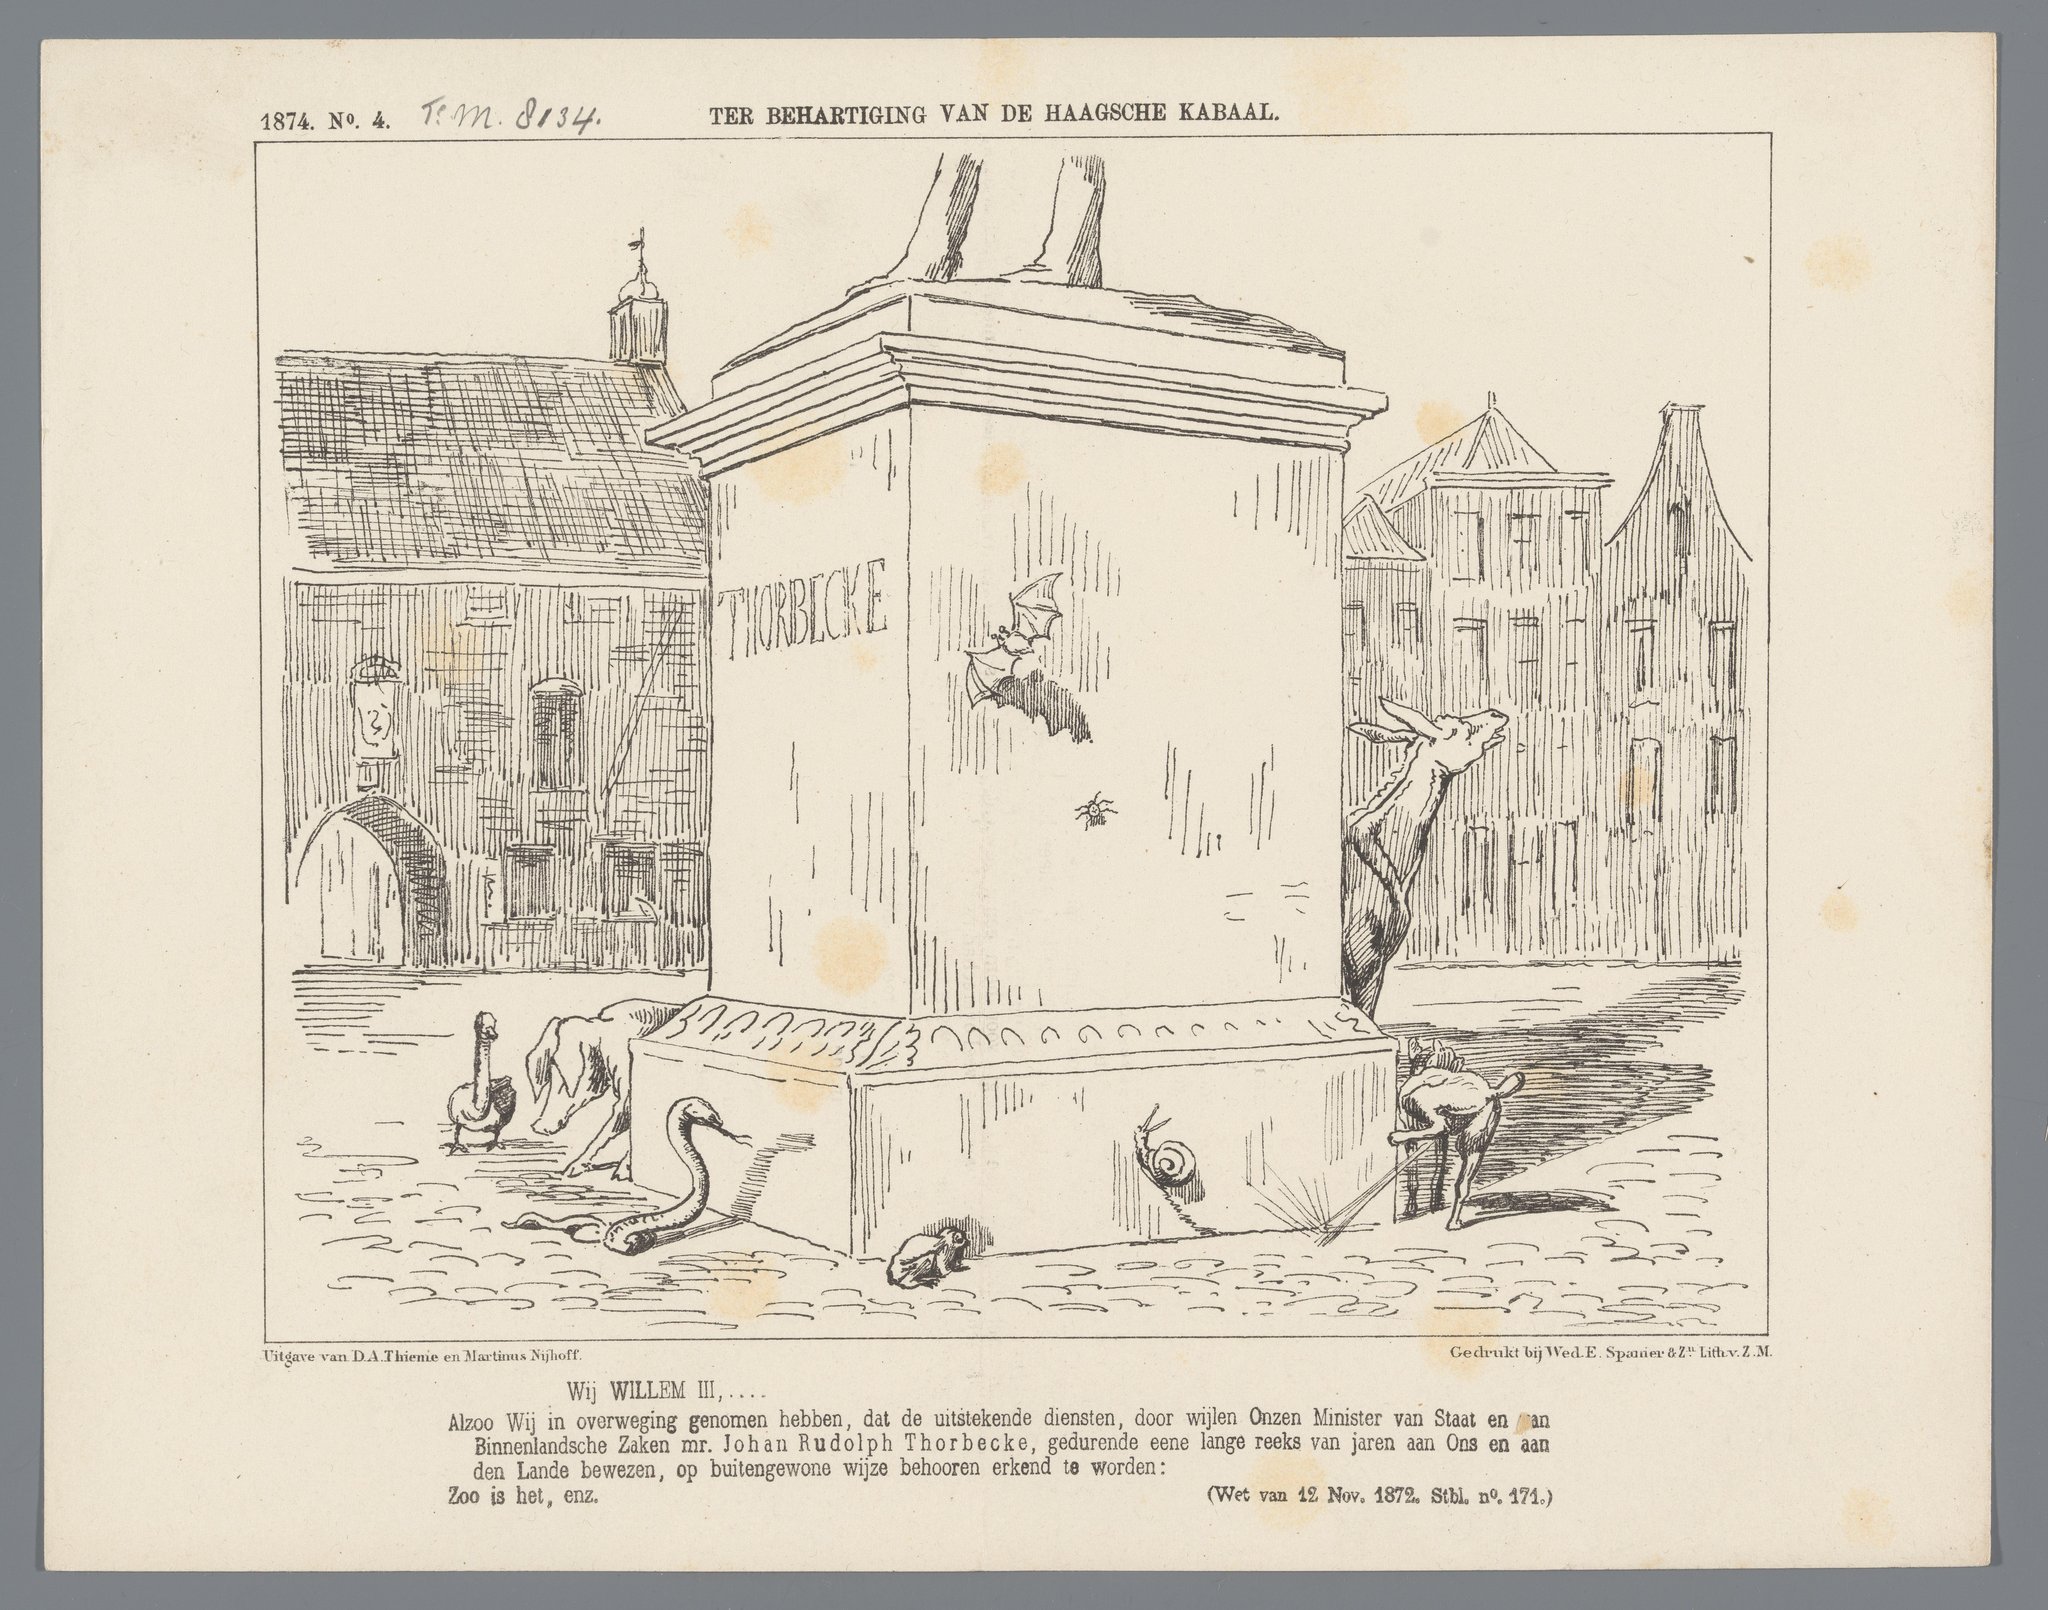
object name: cartoon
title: Ter behartiging van de Haagsche kabaal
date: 1874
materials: paper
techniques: lithograph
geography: netherlands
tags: johan rudolf thorbecke, monument, statue, the hague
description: Spotprent op de intriges in de Haagse gemeenteraad om de plaatsing van het standbeeld van Thorbecke te bemoeilijken, 1874. Plaat verschenen bij het weekblad De Nederlandsche Spectator, nr. 4, 1874.